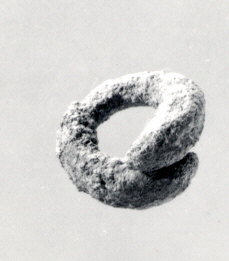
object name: spiral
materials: silver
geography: syria